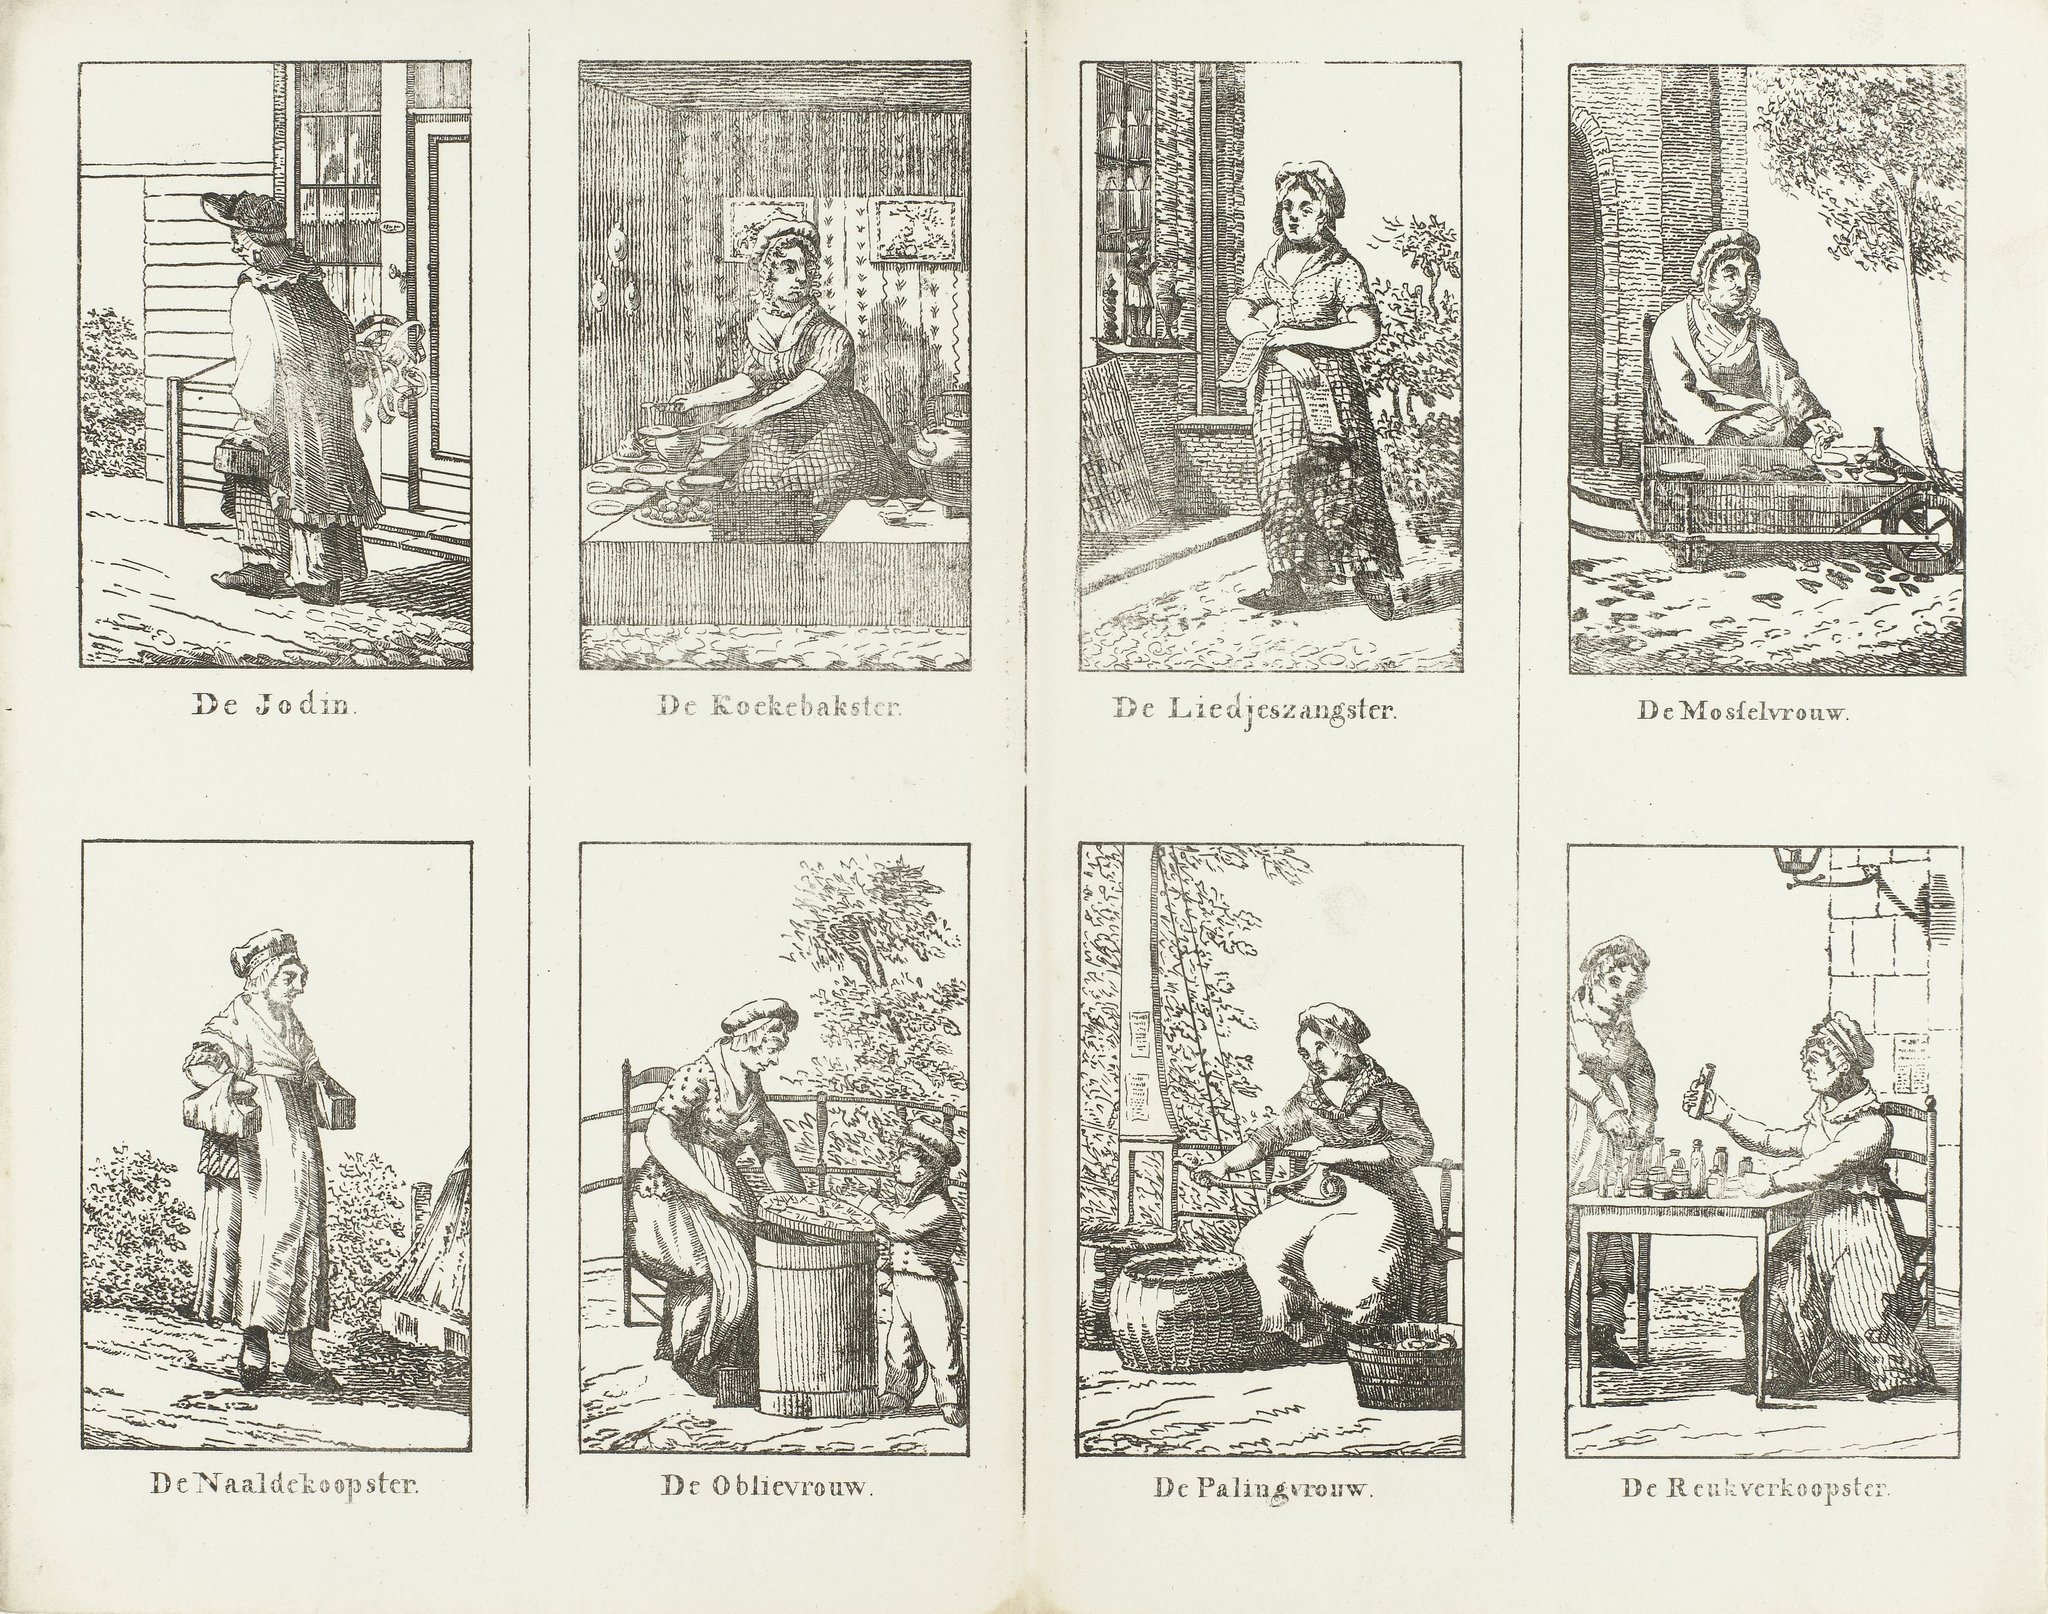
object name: print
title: Beroepen alfabet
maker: Anonymous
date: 1825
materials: paper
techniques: lithograph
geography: rotterdam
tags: street-trader - bb - women engaged in trade and commerce, ballad singer, ballad seller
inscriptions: collector's mark: Lugt 2760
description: Blad met 8 voorstellingen van de letters van het alfabet (J-R) geïllustreerd met vrouwelijke beroepen waarvan de woorden met de betreffende letter beginnen. Onder elke afbeelding een onderschrift.